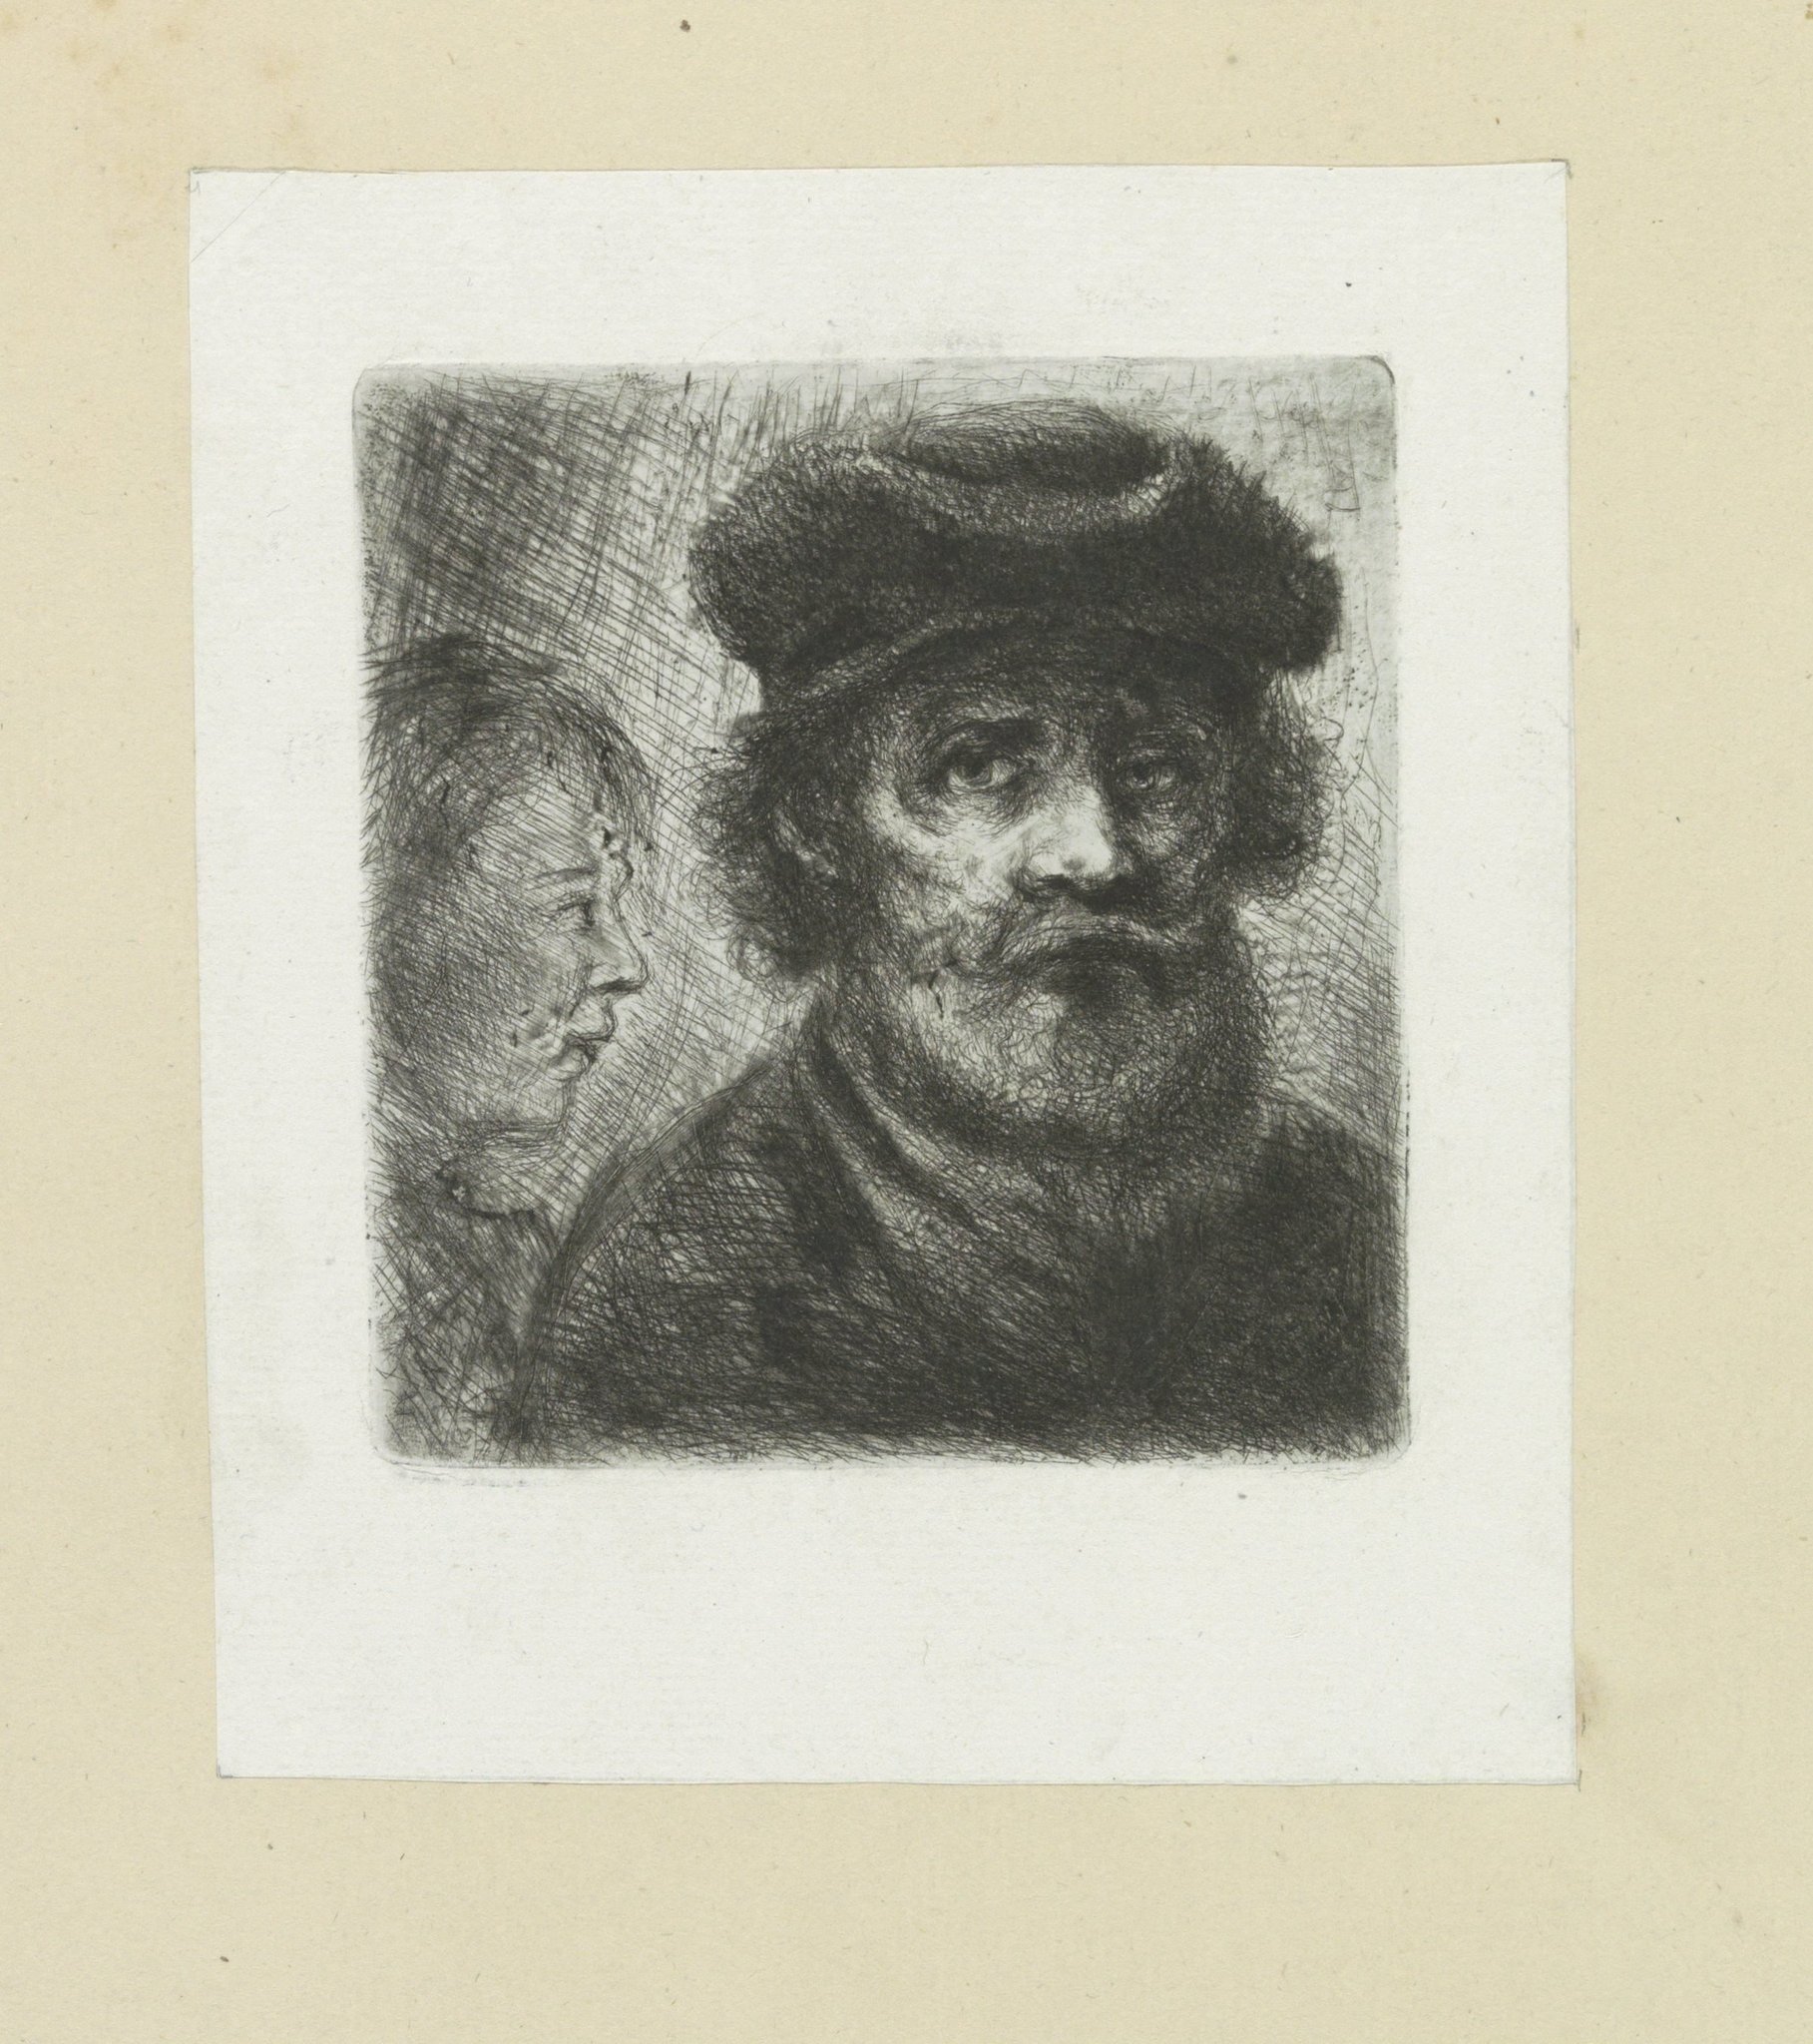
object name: print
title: The Compleat Work of Etchings by John Chalon / Oeuvre Complette des Eaux Fortes par Jean Chalon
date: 1802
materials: paper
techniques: drypoint, etching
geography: london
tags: morphology of human expression (+ adult male (human being)), morphology of human expression (+ young male (human being))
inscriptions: collector's mark: ‘RIJKS / MUSM’, collector's mark: ‘B’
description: Een volwassen man met pet. Links van hem een gezicht van een jongen in profiel naar rechts. De prent maakt deel uit van een album.